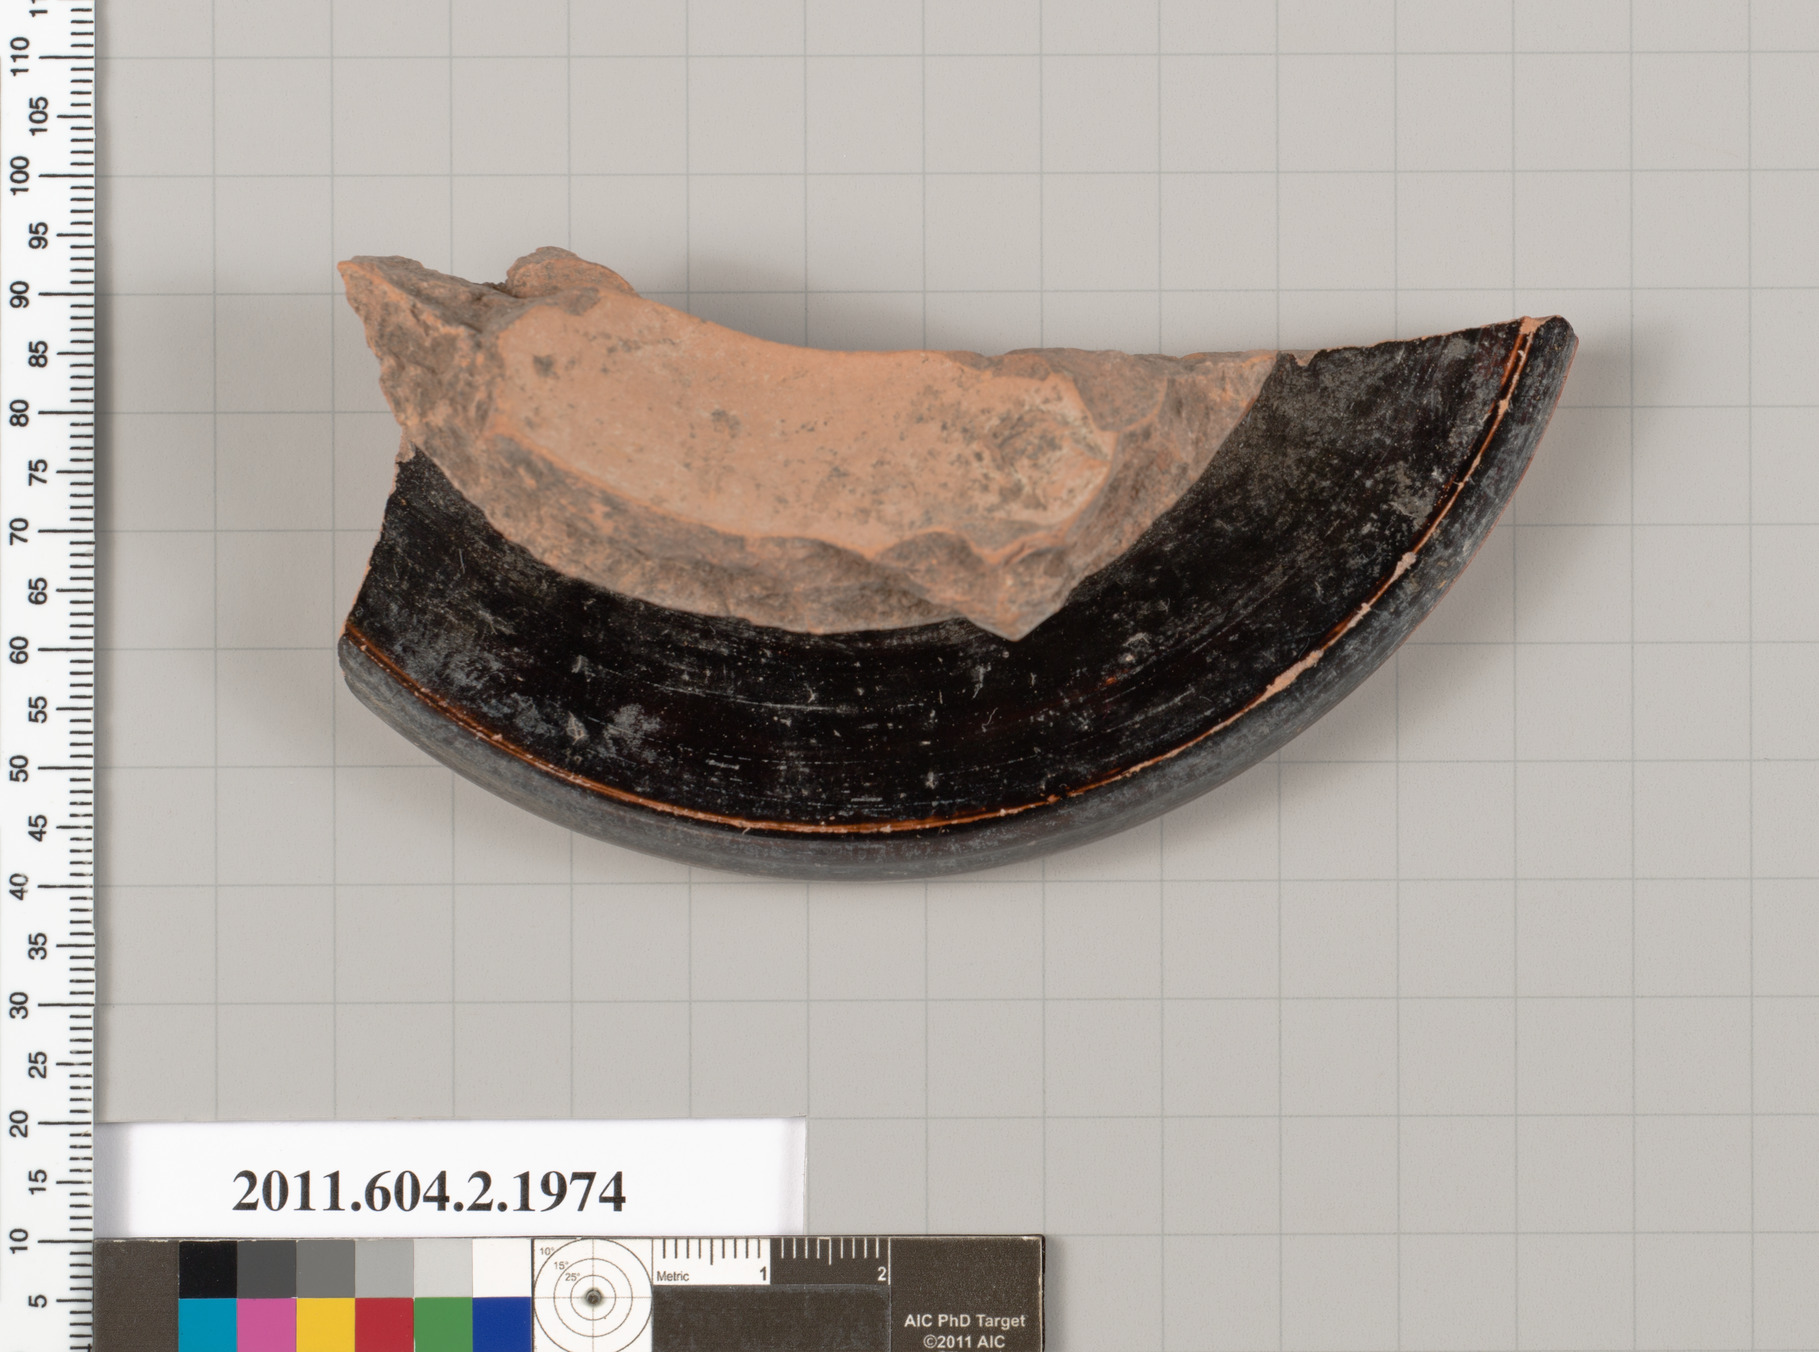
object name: neck amphora fragment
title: Terracotta fragment of a Nolan neck-amphora (jar)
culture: greek, attic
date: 475-451 BCE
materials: terracotta